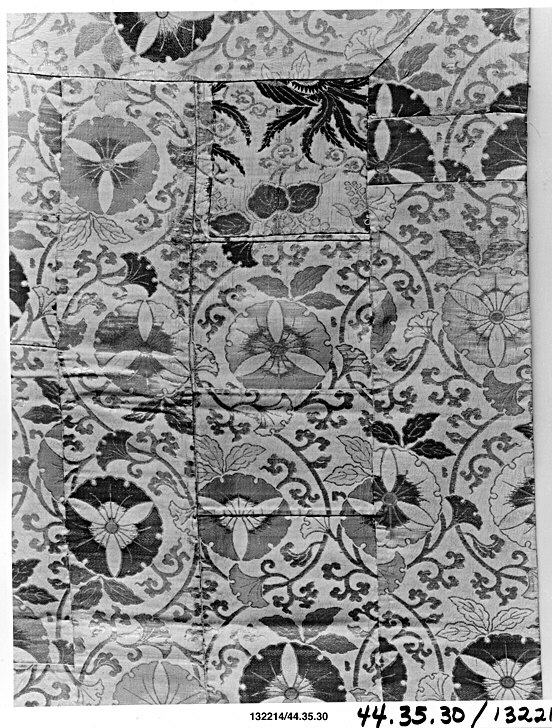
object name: robe, priest's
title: Part of Priest's Robe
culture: japanese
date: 1801-1833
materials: metal thread, silk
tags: leaves